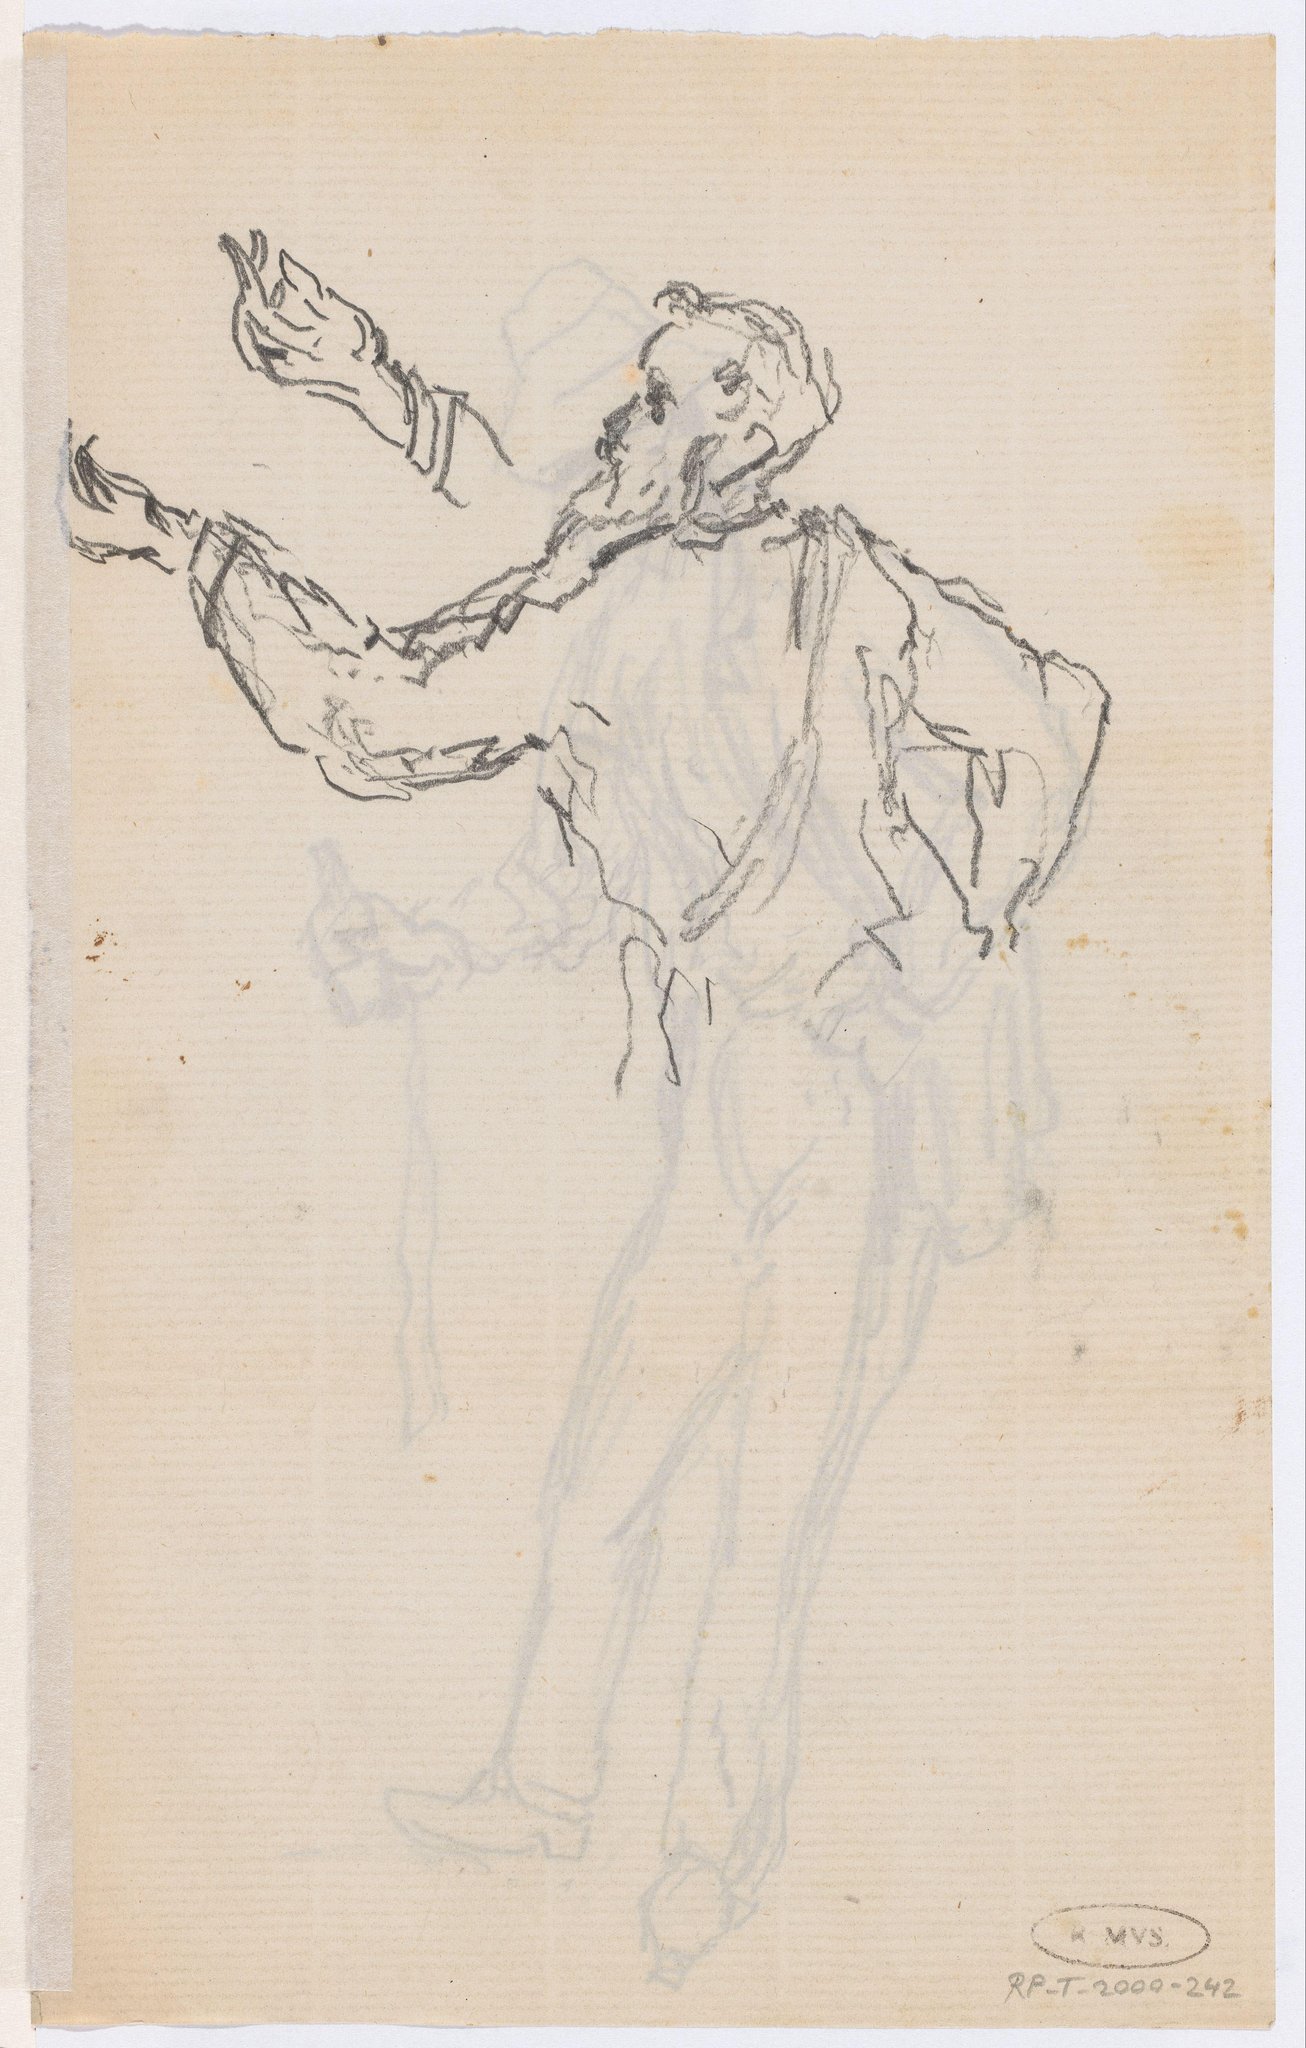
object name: drawing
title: Schets van een man met uitgestoken hand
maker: johannes tavenraat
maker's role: draughtsman, painter, print maker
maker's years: 1809-1881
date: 1840-1880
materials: paper, pencil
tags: drunkenness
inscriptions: collector's mark: Lugt 2228